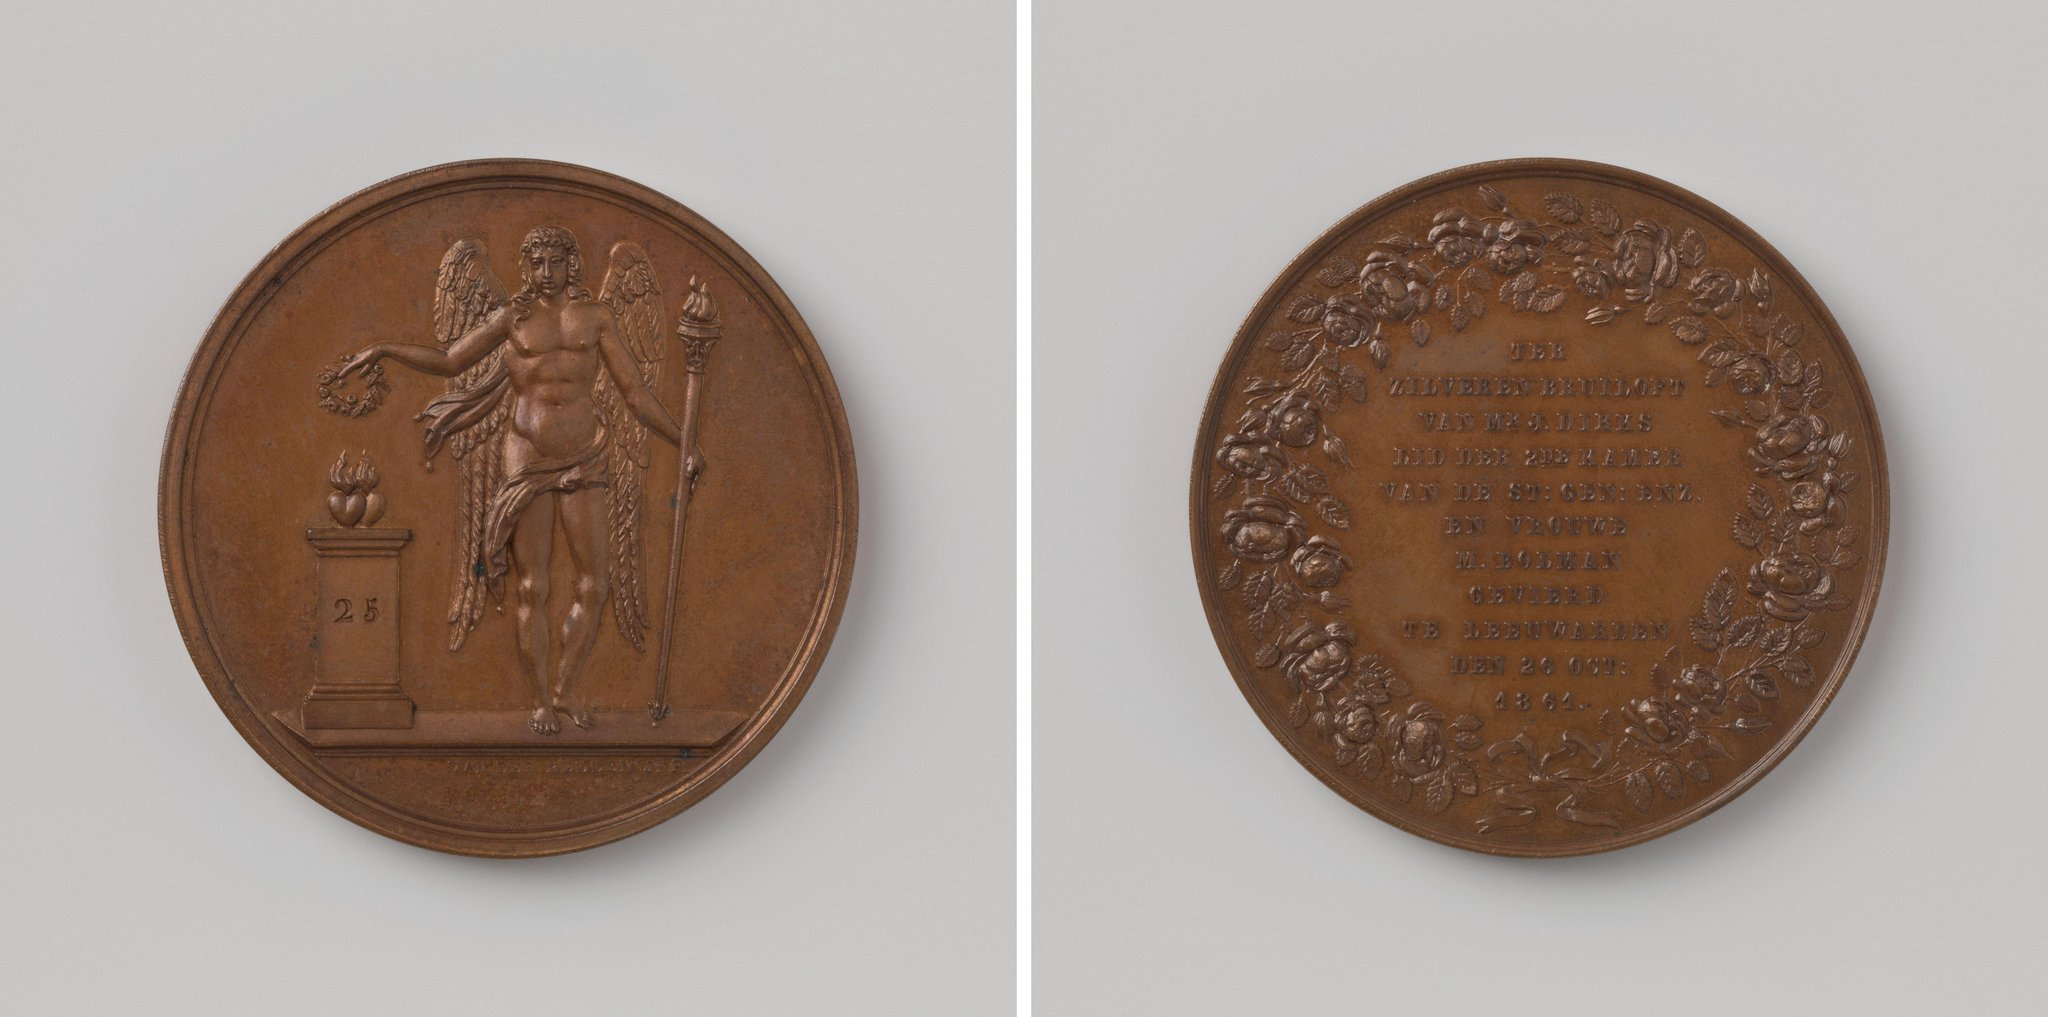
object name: family medal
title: Vijfentwintigjarig huwelijk van Jacob Dirks, lid van de Tweede Kamer en Minschje Bolman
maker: david van der kellen (1804-1879)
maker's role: die cutter, draughtsman, print maker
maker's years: 1804-1879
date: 1861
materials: bronze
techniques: engraving, striking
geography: utrecht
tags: minschje bolman, leeuwarden, minister, jacob dirks, staten-generaal, tweede kamer der staten-generaal